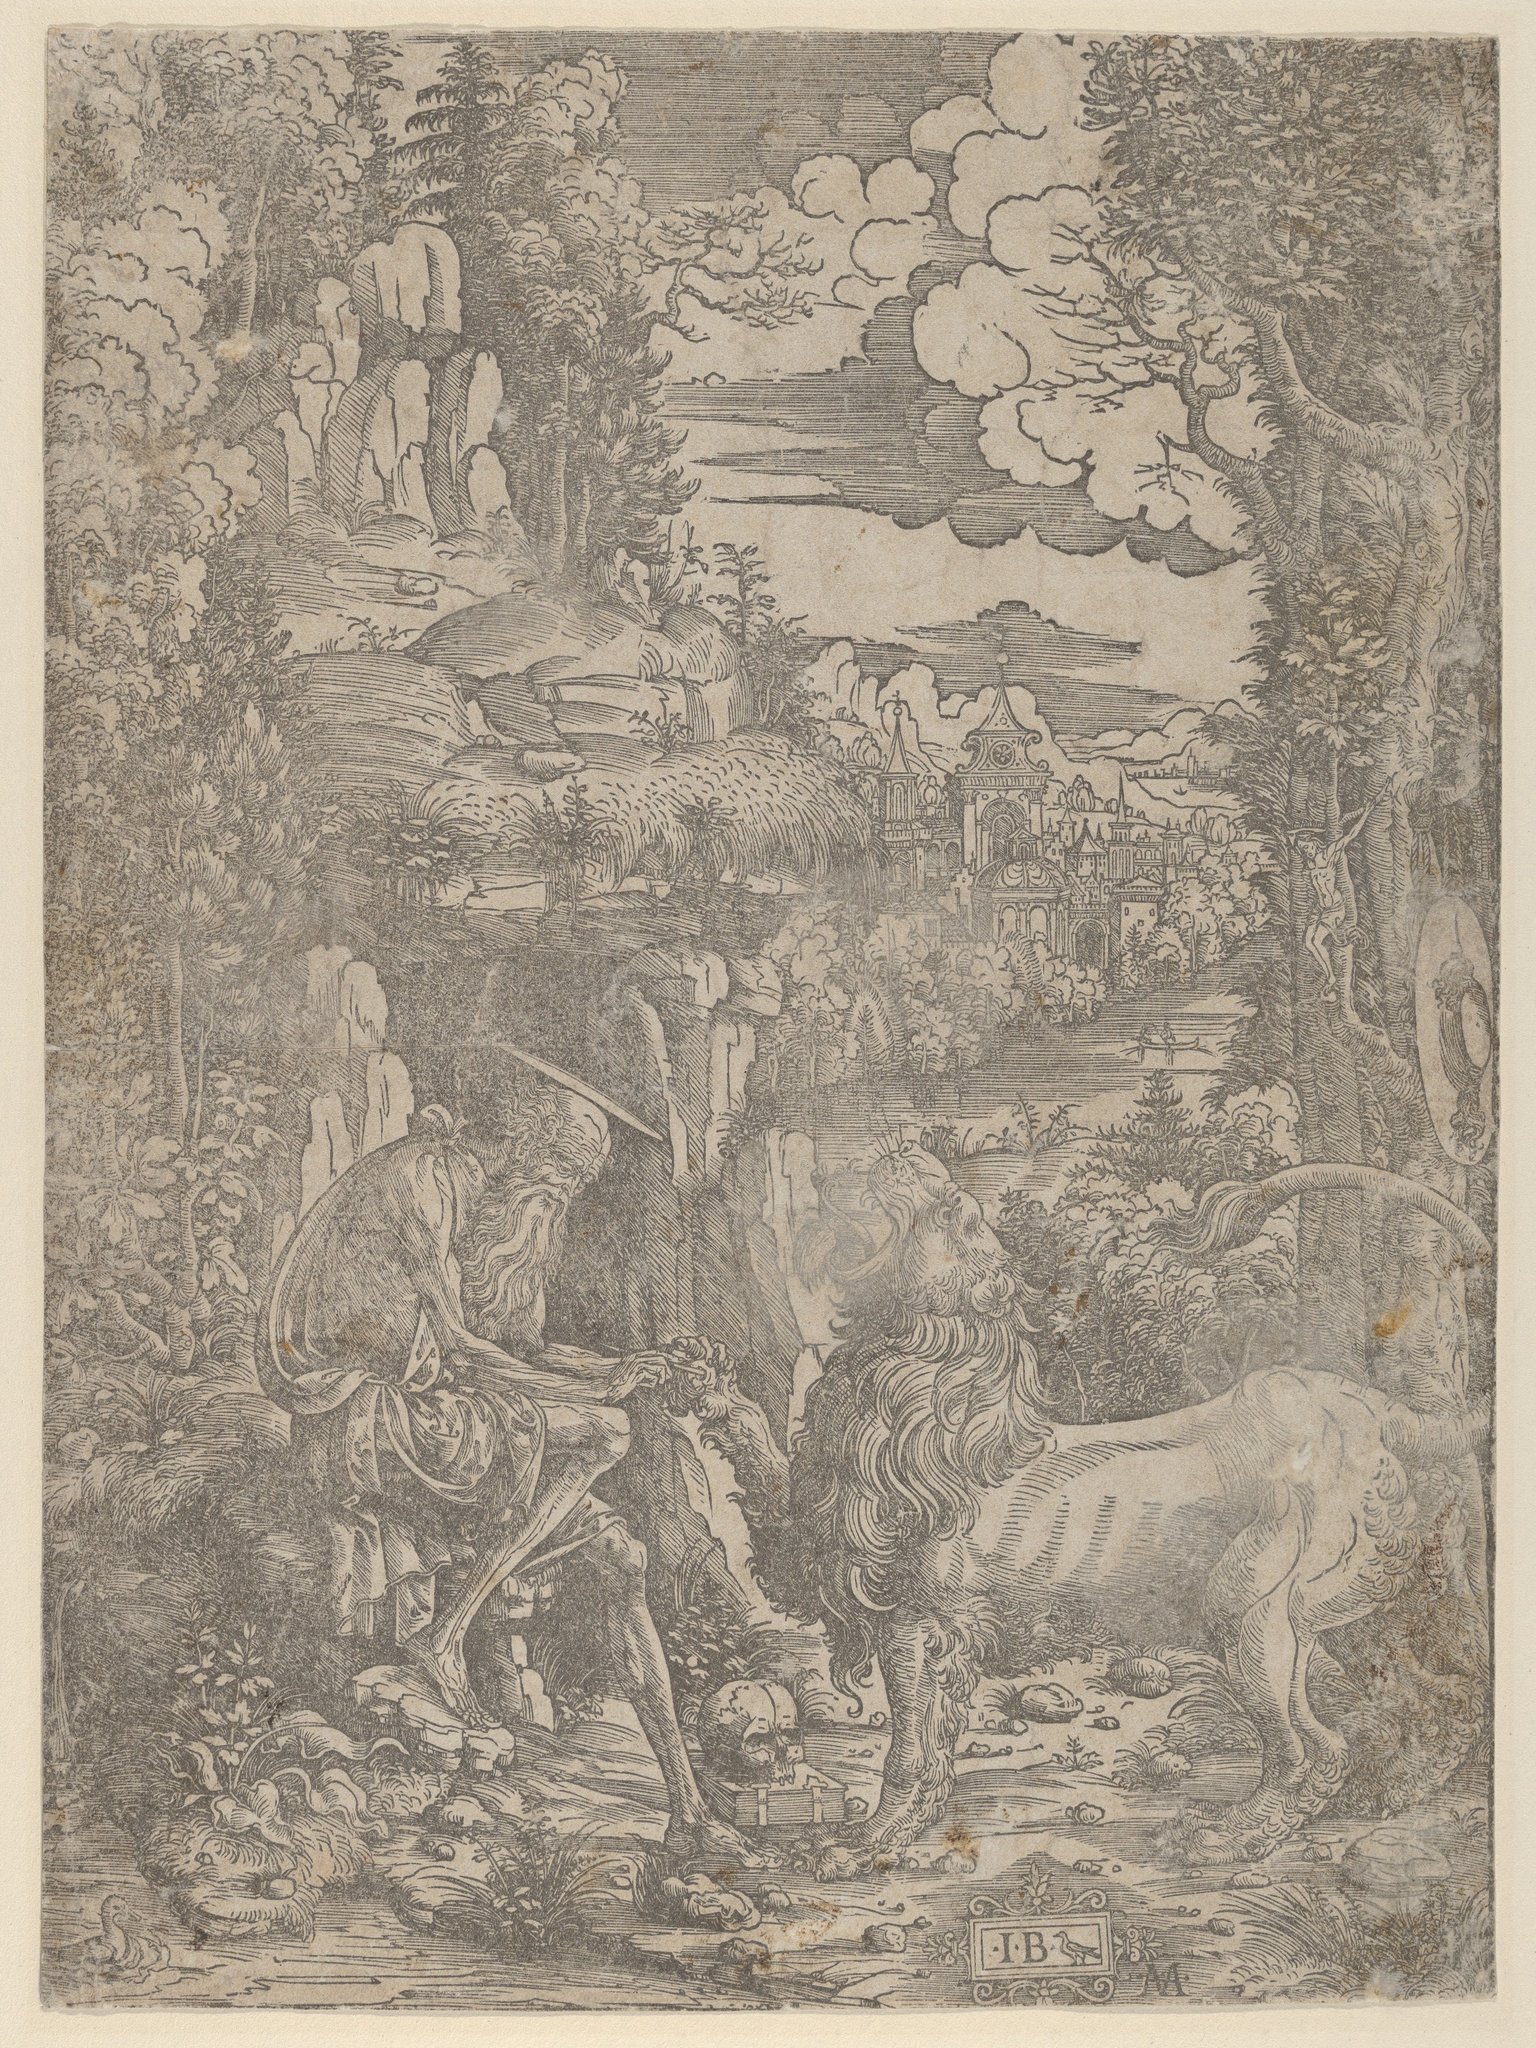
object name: print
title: Saint Jerome extracting a thorn from the lion's paw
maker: giovanni battista palumba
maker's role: artist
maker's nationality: italian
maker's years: 1495-1520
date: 1500-1510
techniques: woodcut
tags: lions,saint jerome